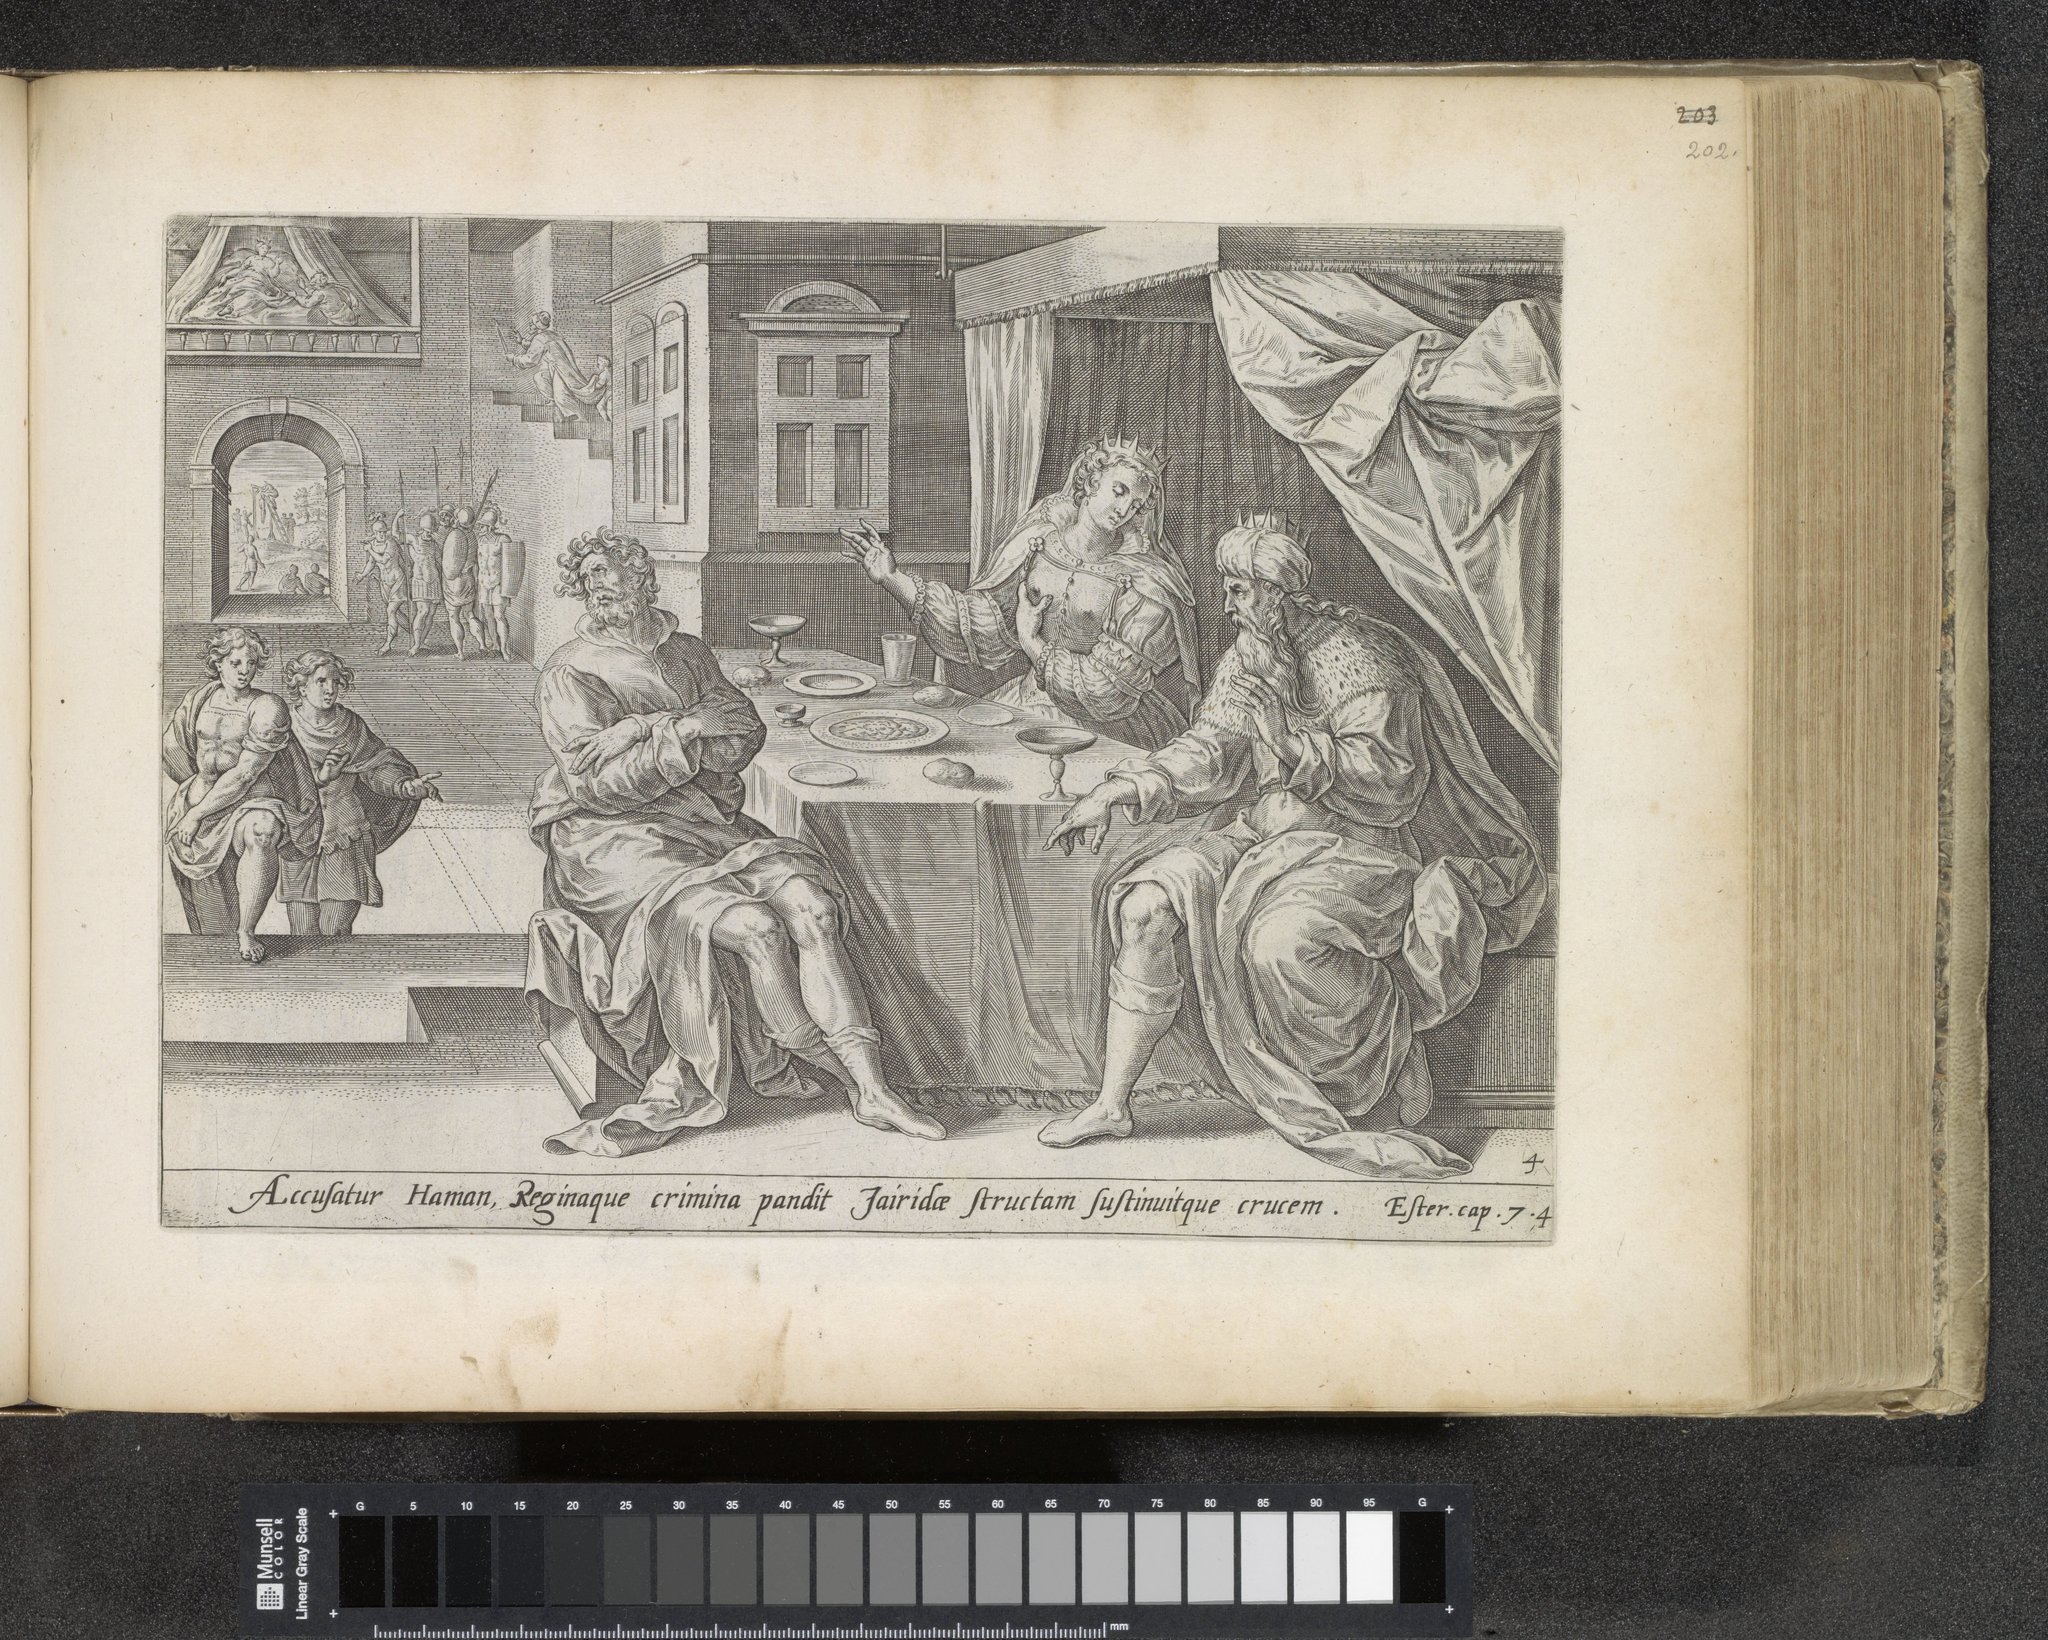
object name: print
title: Geschiedenis van Ester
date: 1579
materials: paper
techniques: engraving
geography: amsterdam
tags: as haman is kneeling at esther's feet or is prostrated on her couch king ahasuerus returns; haman is condemned to be hanged, esther accuses haman, haman on the gallows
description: Koning Ahasveros en zijn ambtenaar Haman zitten bij Ester aan tafel. Ester beschuldigt Haman van de geplande moord op het Joodse volk. Op de achtergrond is te zien hoe Haman vervolgens knielt bij het bed van koningin Ester en haar smeekt om zijn leven. Koning Ahasveros loopt op de trap en zal Haman beschuldigen van aanranding. Links is door een deur te zien hoe Haman wordt opgehangen. Onder de voorstelling een verwijzing in het Latijn naar de Bijbeltekst in Est. 7:4. Deze prent maakt deel uit van een album.